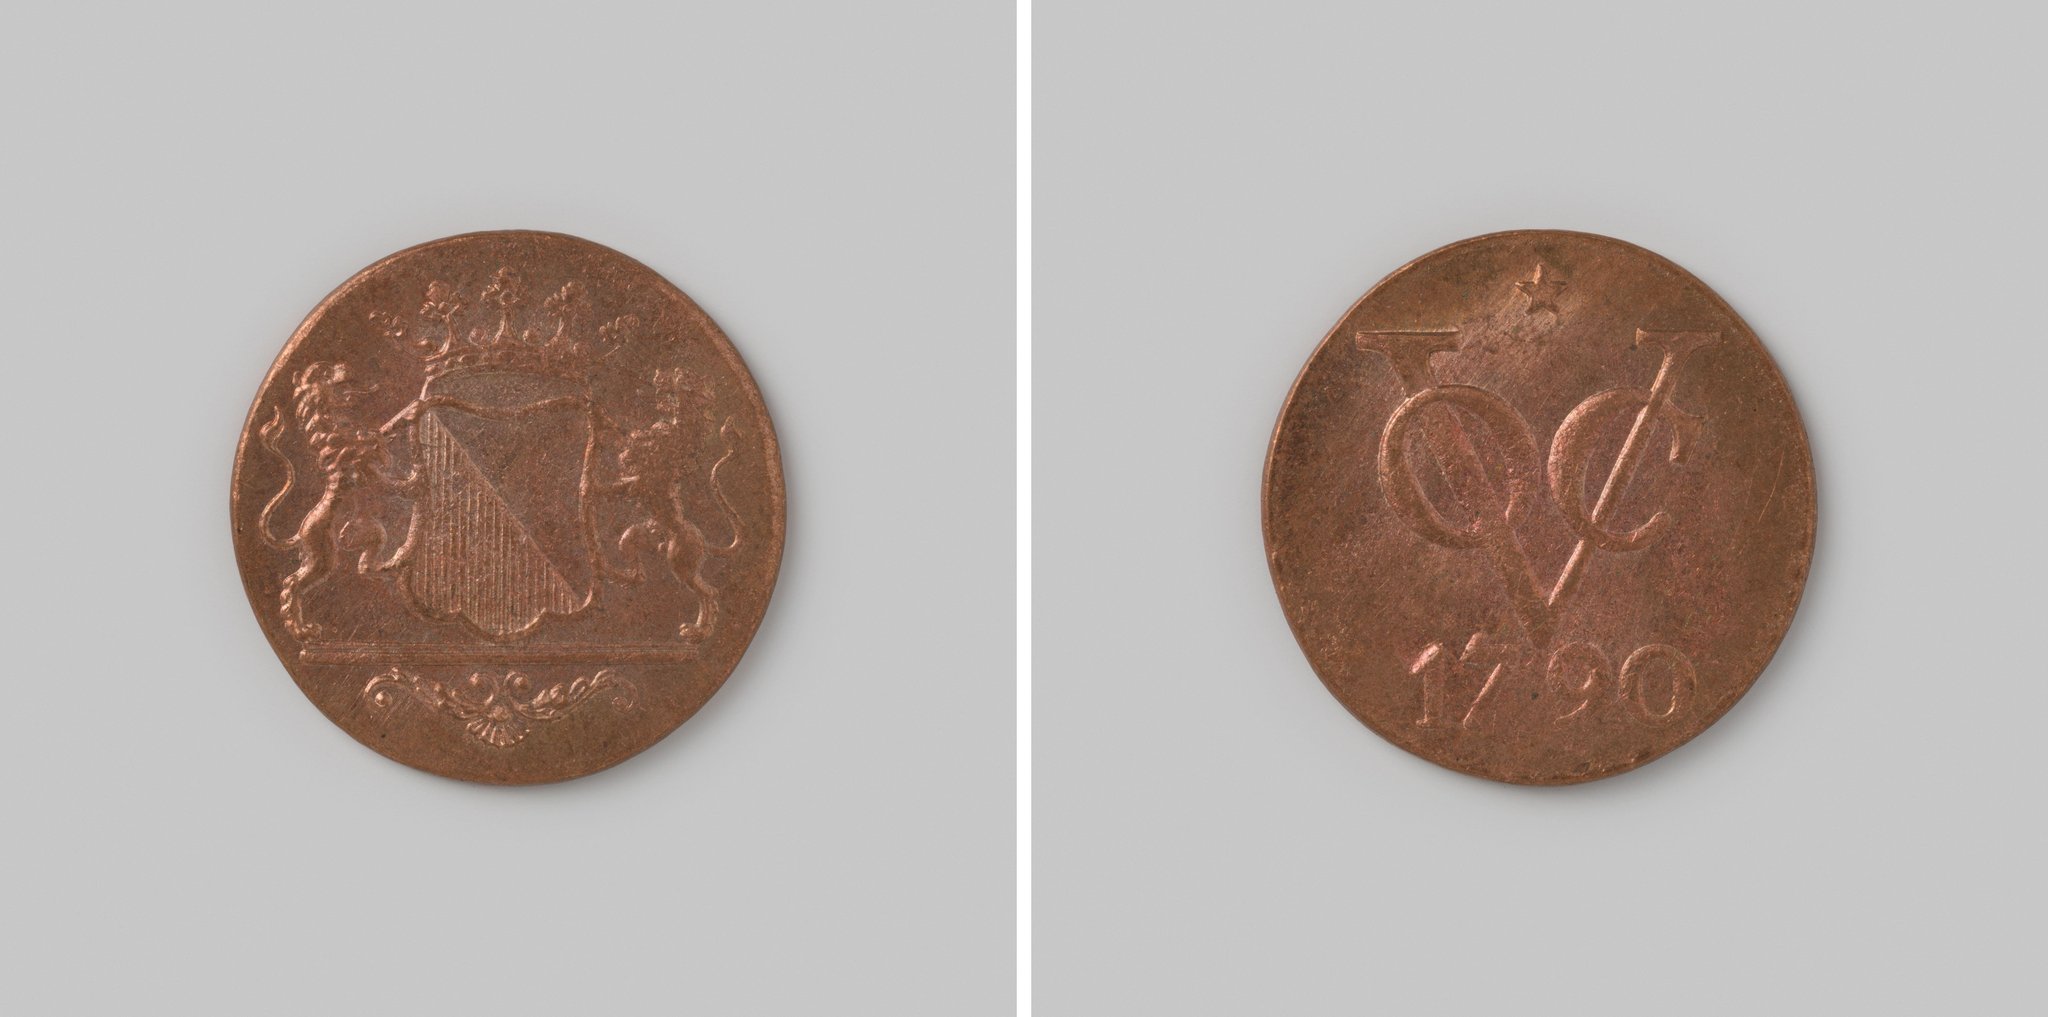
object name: coin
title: VOC, dubbele duit op naam van de stad Utrecht met jaartal1790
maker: william ii of the netherlands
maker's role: koning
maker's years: 1792-1849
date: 1840-1843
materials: copper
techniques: striking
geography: surabaya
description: Koperen munt. Voorzijde: op balk, waaronder guirlande, staand, door twee leeuwen gehouden gekroond wapenschild van de stad Utrecht. Keerzijde: monogram van de VOC, waarboven muntteken ster en waaronder fictief jaartal 1790. Gladde rand.